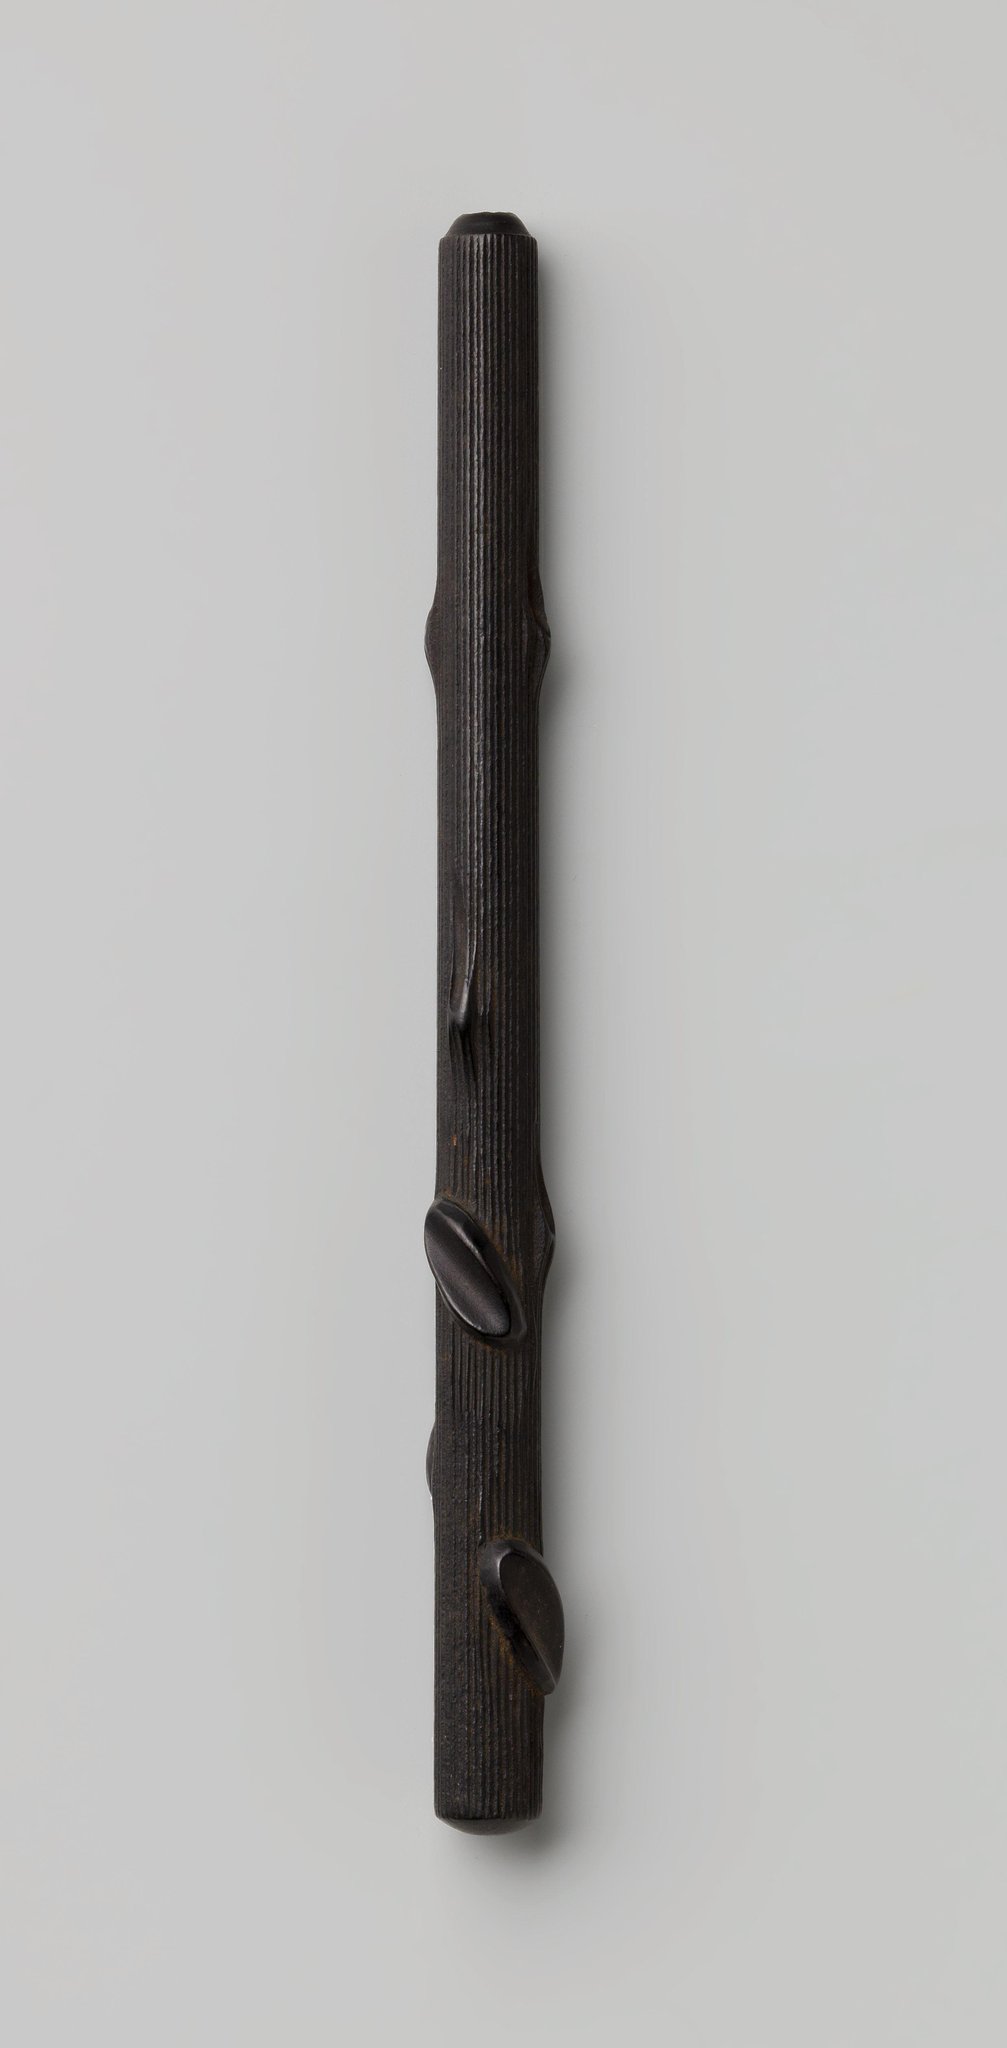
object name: parasolknop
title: Handvat van zwarte kunststof met geribbeld oppervlak en afgesneden stekels, voor een paraplu of parasol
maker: gustav schnitzler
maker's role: paraplufabrikant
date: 1910-1920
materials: plastic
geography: nijmegen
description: Handvat van dofzwarte kunststof voor een paraplu of parasol. Het oppervlak is geribbeld en heeft afgesneden stekels. Mogelijk voor de rouw.